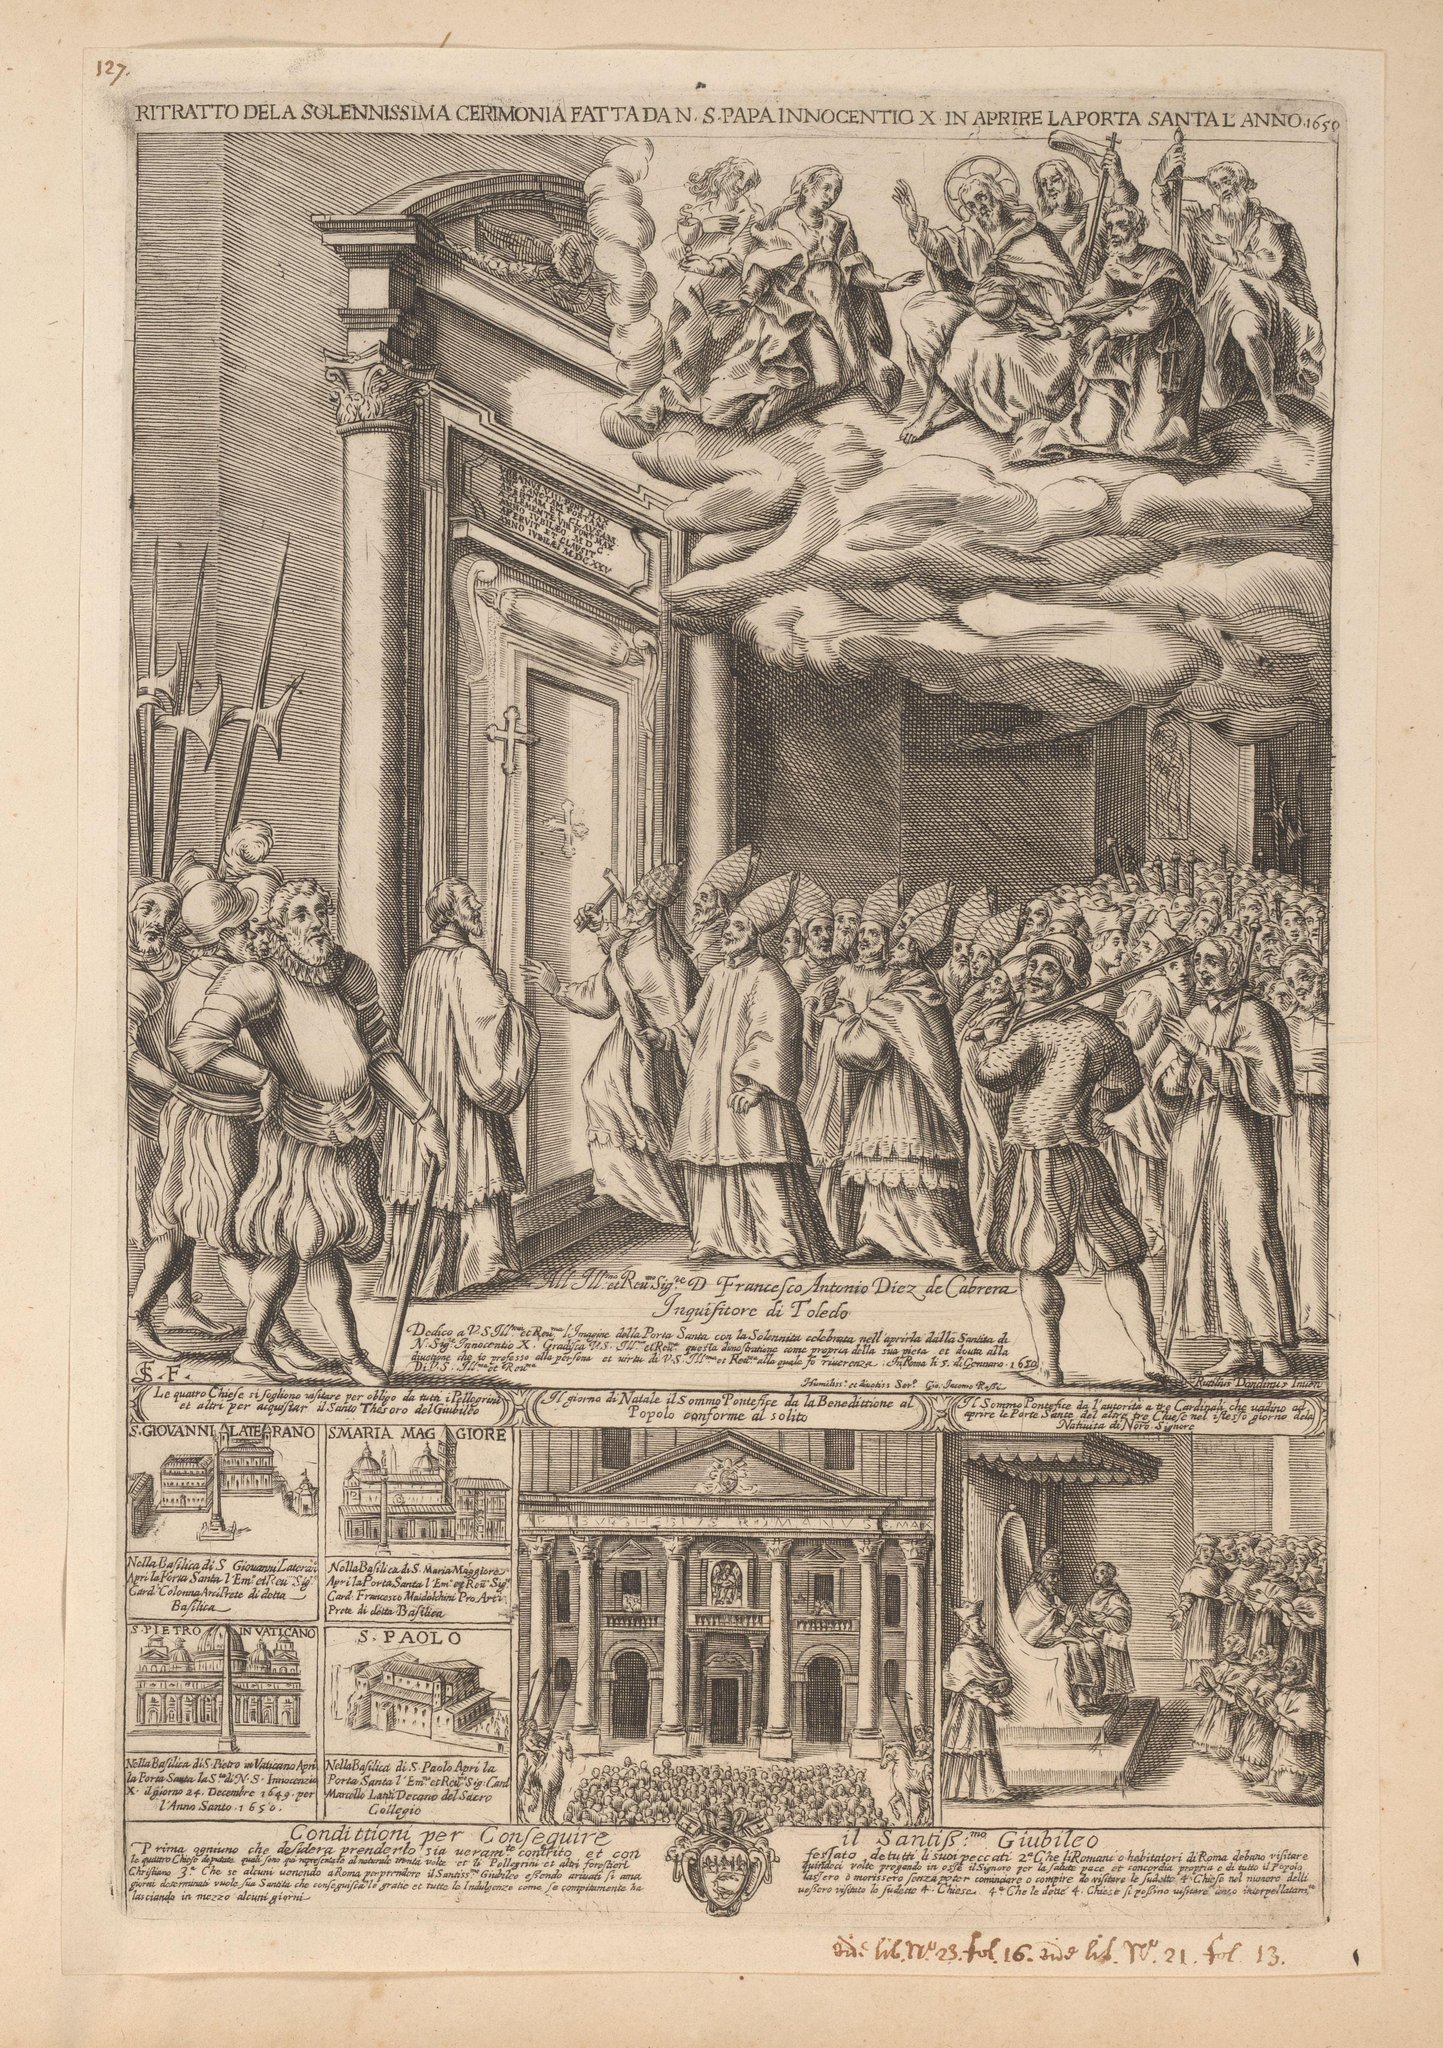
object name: album leaf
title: Innocentius X opent de Heilige Deur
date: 1650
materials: paper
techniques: engraving, intaglio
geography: rome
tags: rome, innocentius x, adult christ together with others (non-narrative representations), church (exterior), opening the door, pope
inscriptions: number: ‘127’, number: ‘1’, number: ‘83’, inscription: ‘[...] lib. vol. 23. fol. 16 [...] lib. vol. 21. fol. 13.’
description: Paus Innocentius X opent de Heilige Deur in de Sint-Pietersbasiliek ter gelegenheid van de opening van het Heilig Jaar 1650. Prent maakt deel uit van een album.